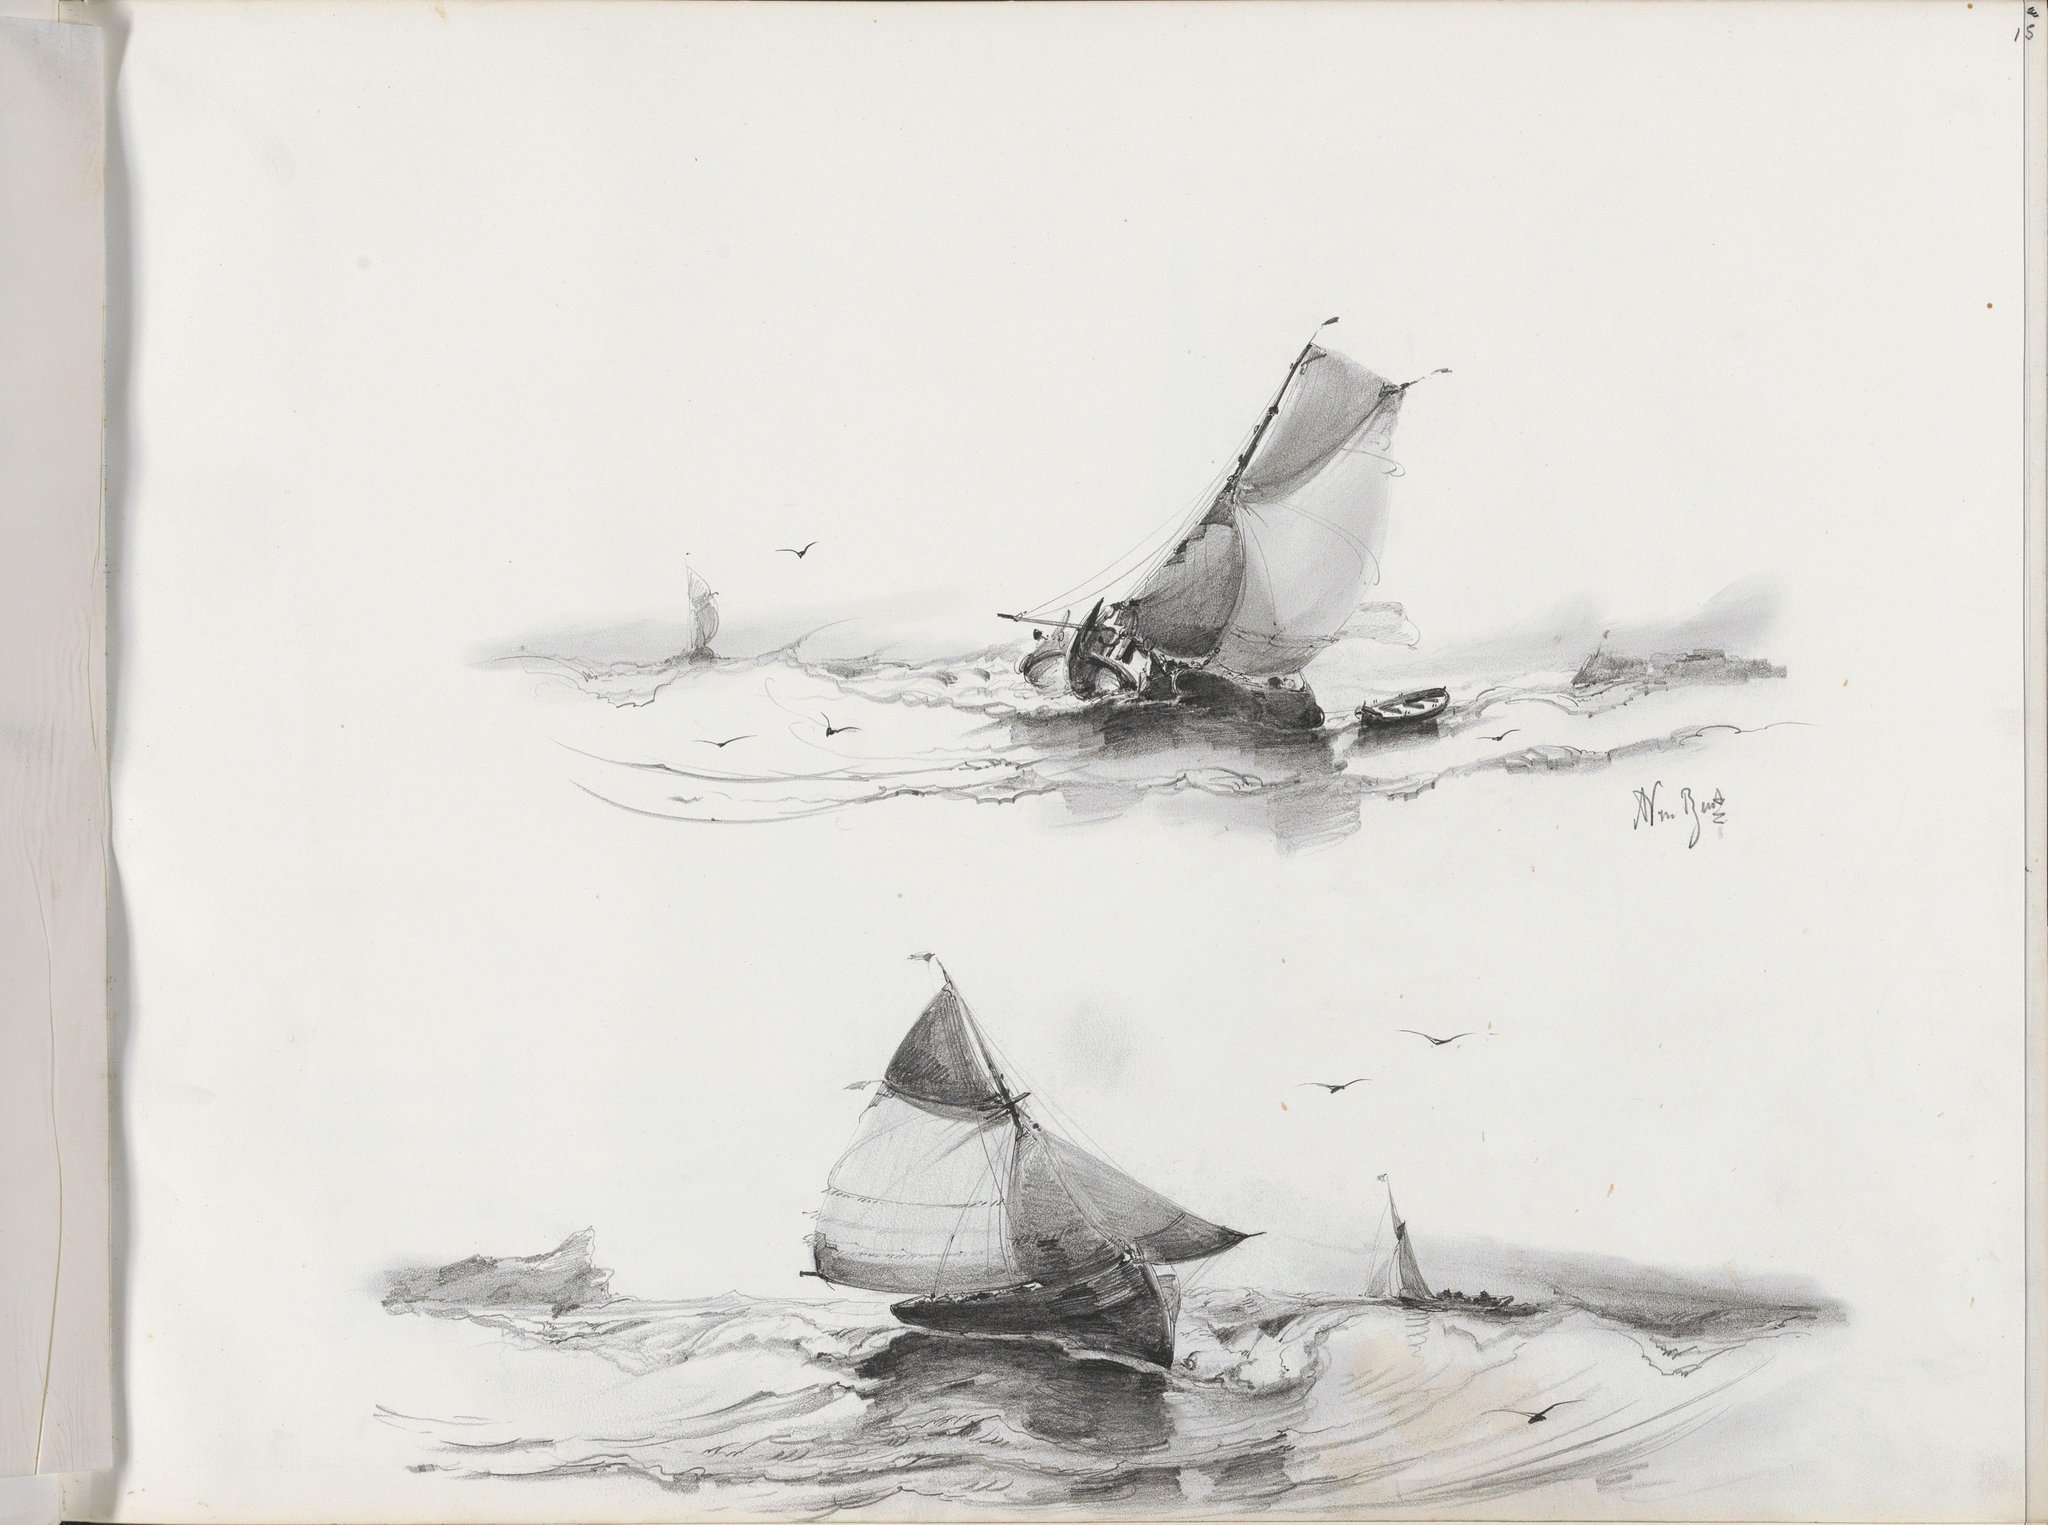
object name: sketchbook leaf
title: Zeilschepen op het water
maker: albertus van beest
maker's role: draughtsman, print maker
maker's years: 1820-1860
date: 1830-1860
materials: paper, pencil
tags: sailing-ship, sailing-boat, landscapes with waters, waterscapes, seascapes (in the temperate zone)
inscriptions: signature: ‘AVan Beest’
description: Blad 15 recto uit een schetsboek met 46 bladen.